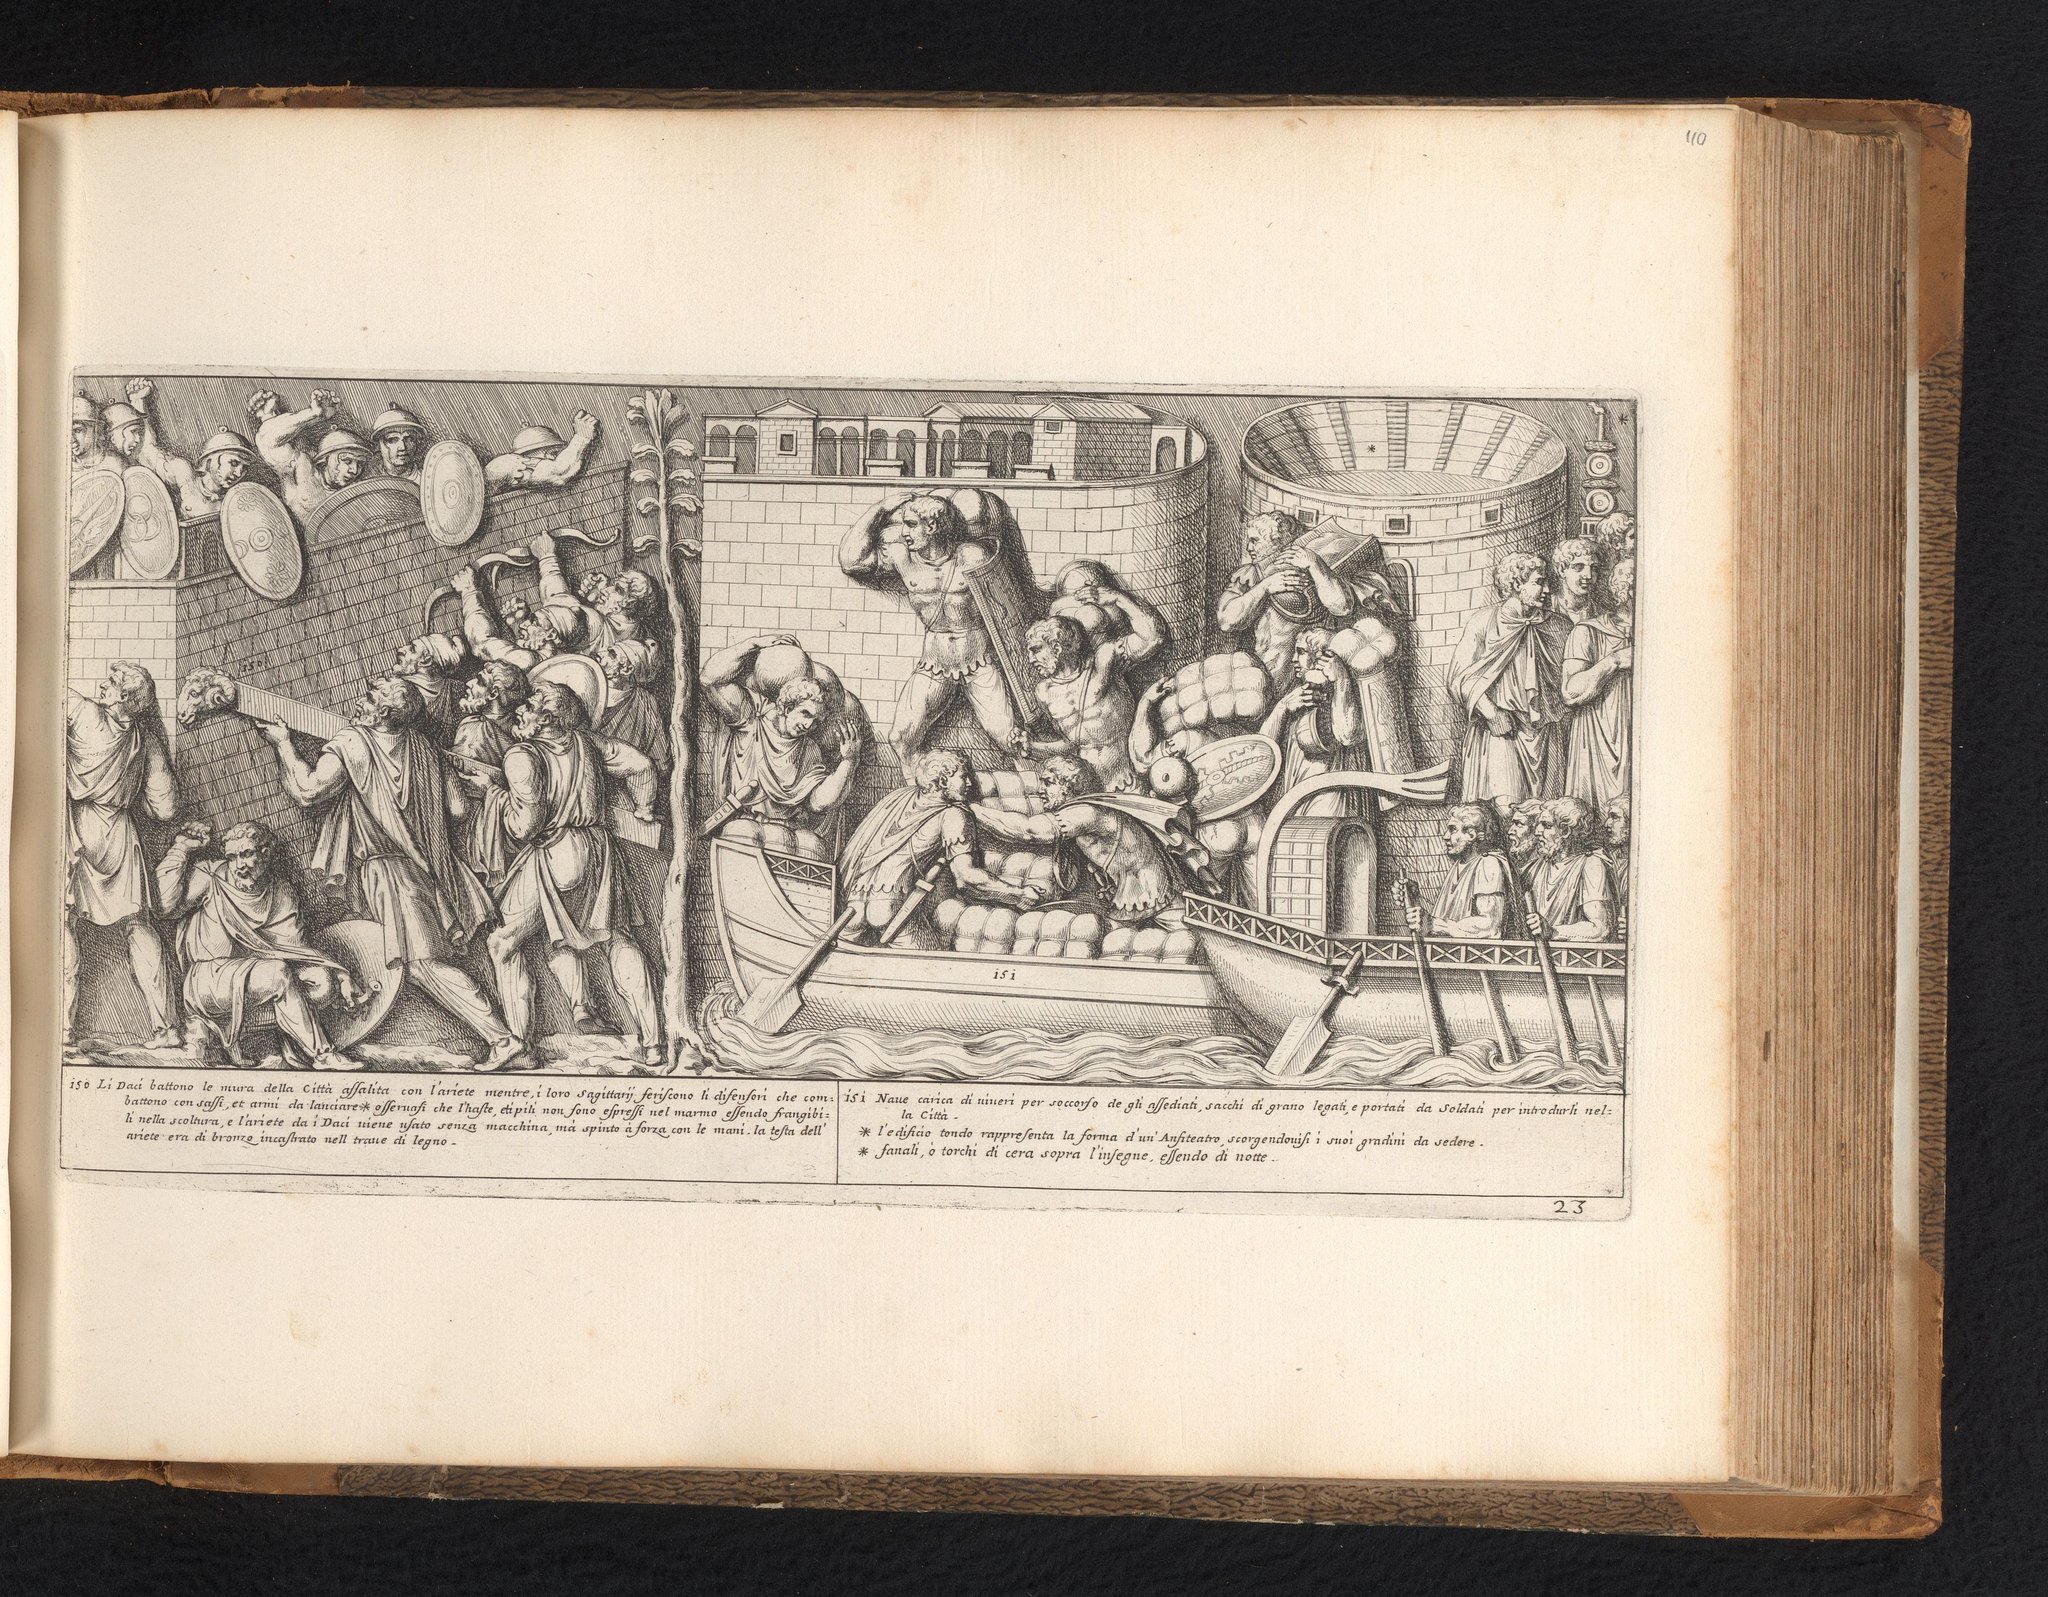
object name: album leaf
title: Colonna Traiana eretta dal senato, e popolo Romano all' imperatore Traiano Augusto nel suo foro in Rom (...)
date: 1637-1691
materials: paper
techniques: etching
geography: rome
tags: triumphal column with helical friezes, piece of sculpture, reproduction of a piece of sculpture, the soldier; the soldier's life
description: Detail van het spiraalvormige gebeeldhouwde fries op de Zuil van Trajanus. Het fries toont de oorlogen tussen de Romeinen en de Daciërs. Verklarende nummers in de ondermarge. Prent maakt deel uit van een album.